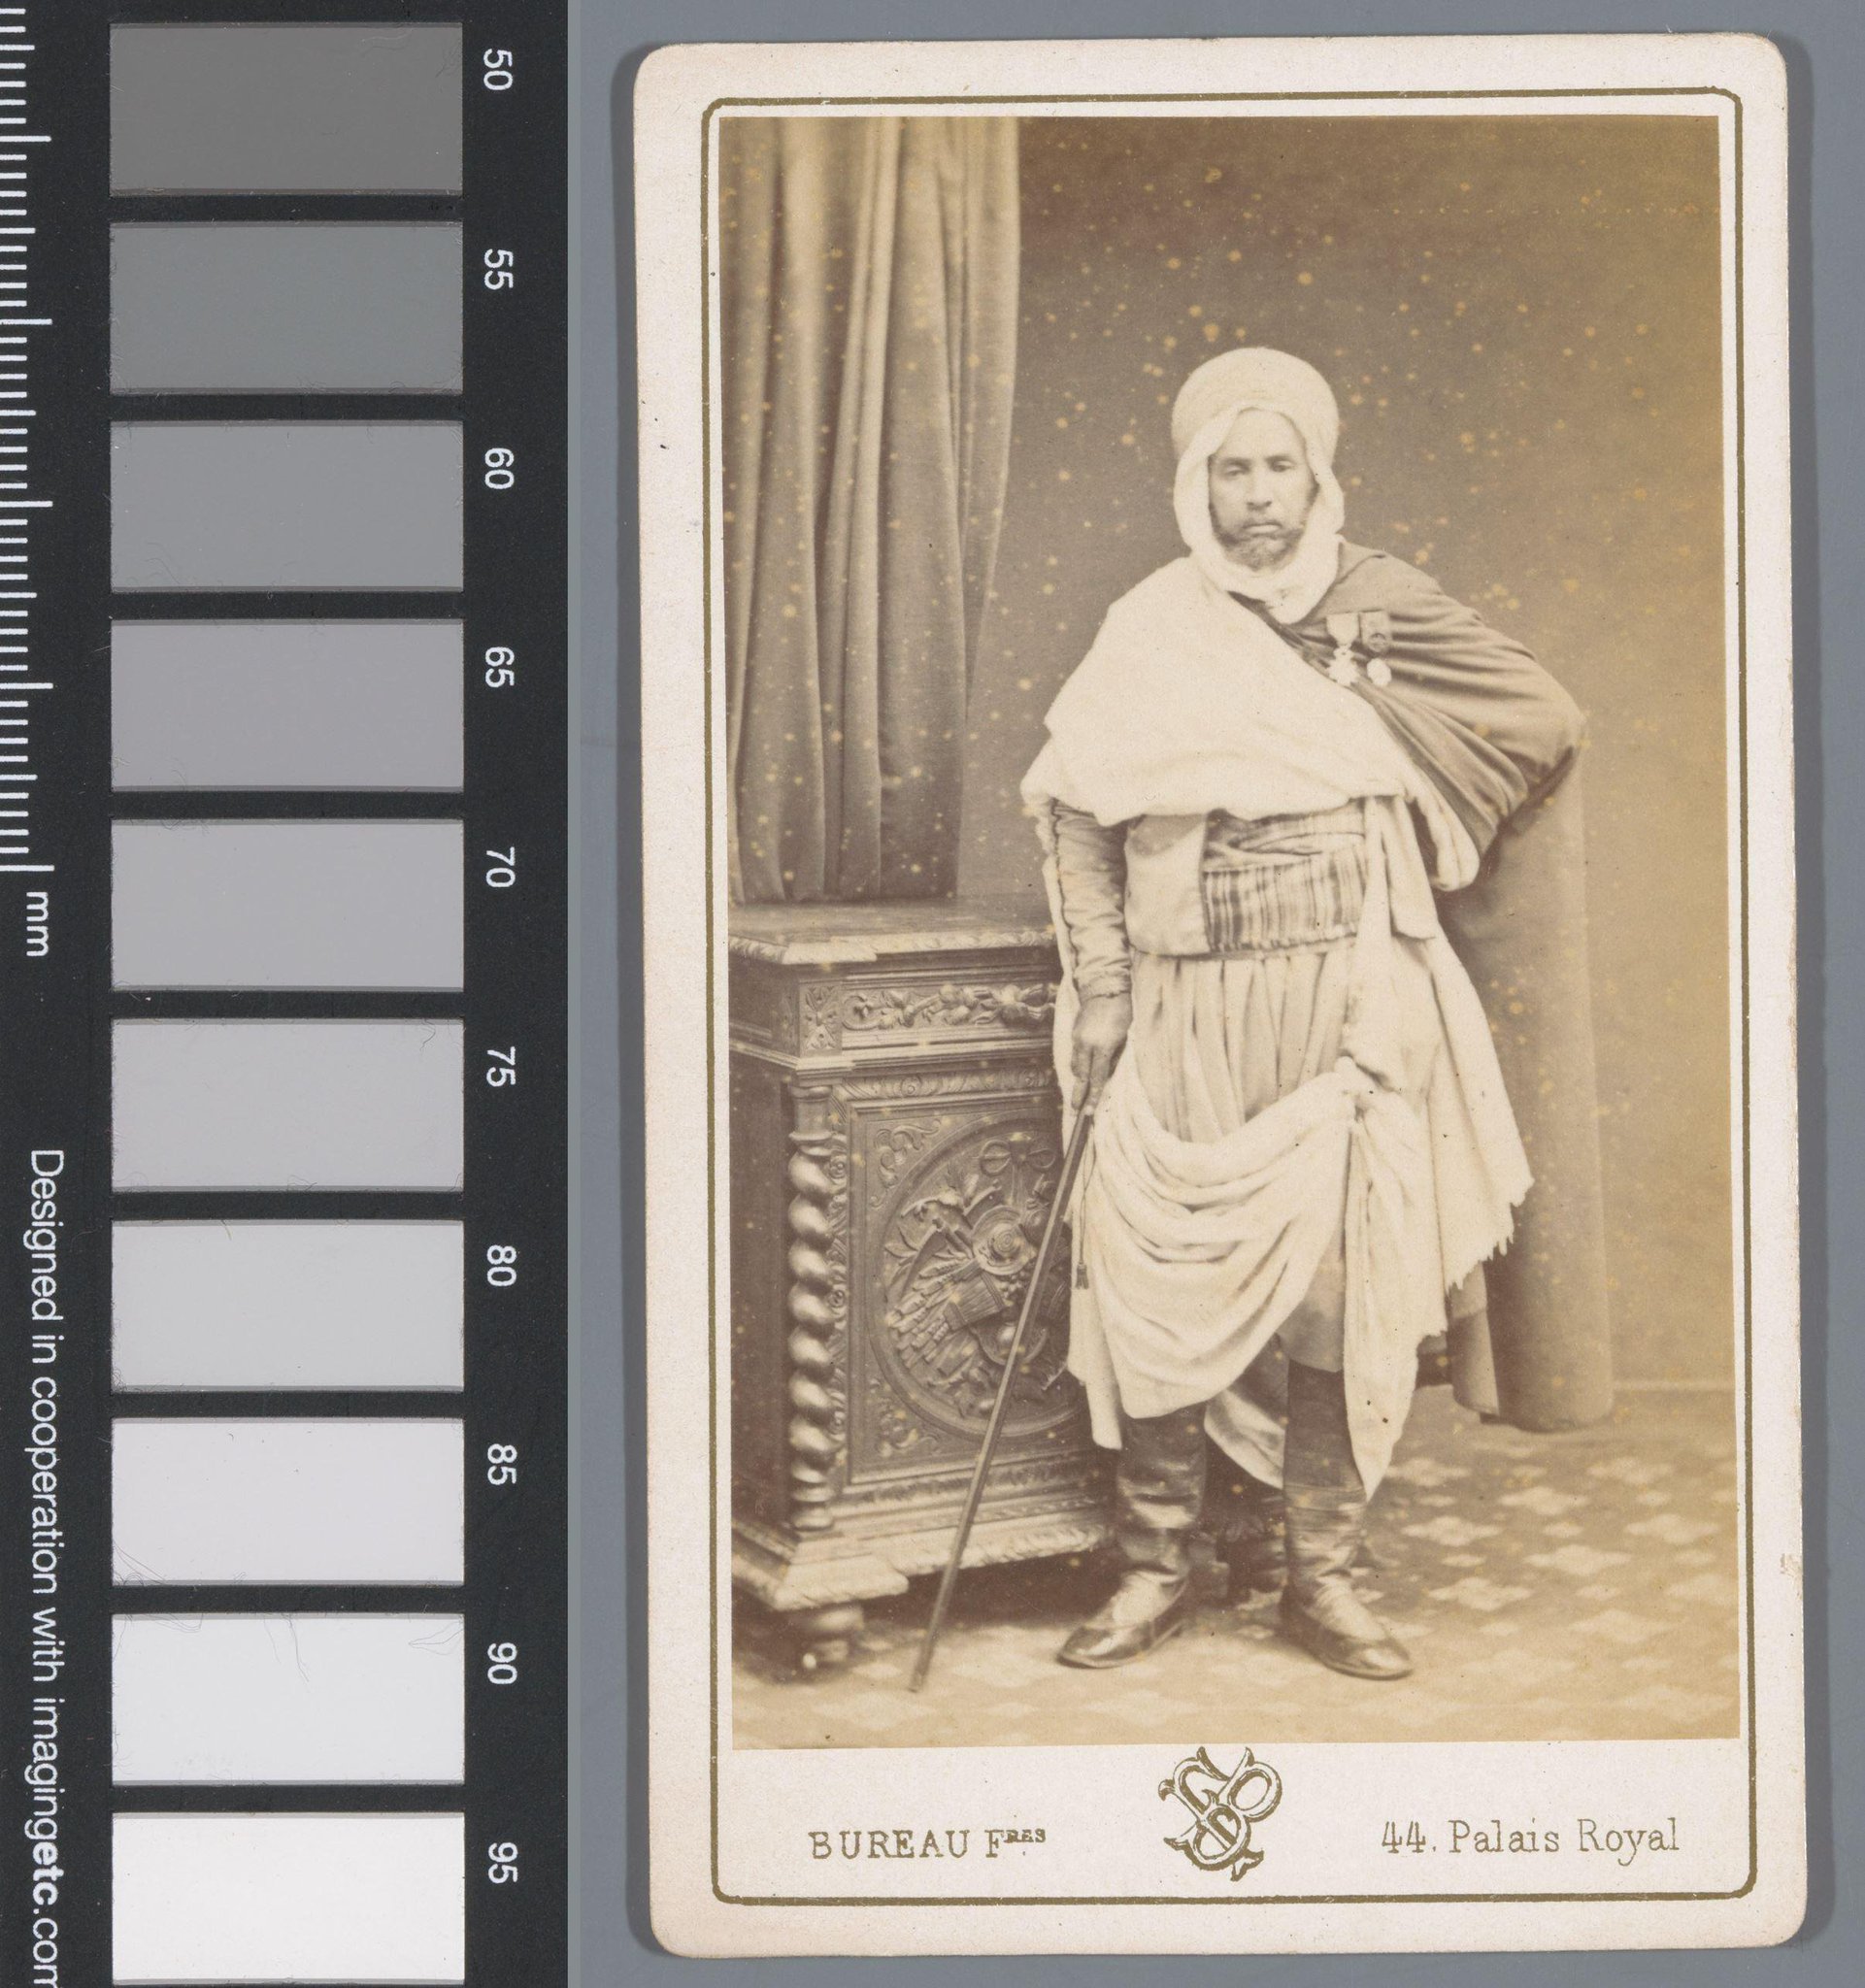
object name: carte de visite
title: Portret van een onbekende Arabische man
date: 1868-1885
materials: cardboard, paper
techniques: albumen print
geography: paris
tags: adult man, anonymous historical person portrayed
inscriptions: address: ‘44, Galerie Montpensier/ PALAIS ROYAL/ PARIS’, inscription: ‘POUR LES VOITURES/ 28. Rue Montpensier/ Tous les Clichés sont conservés’